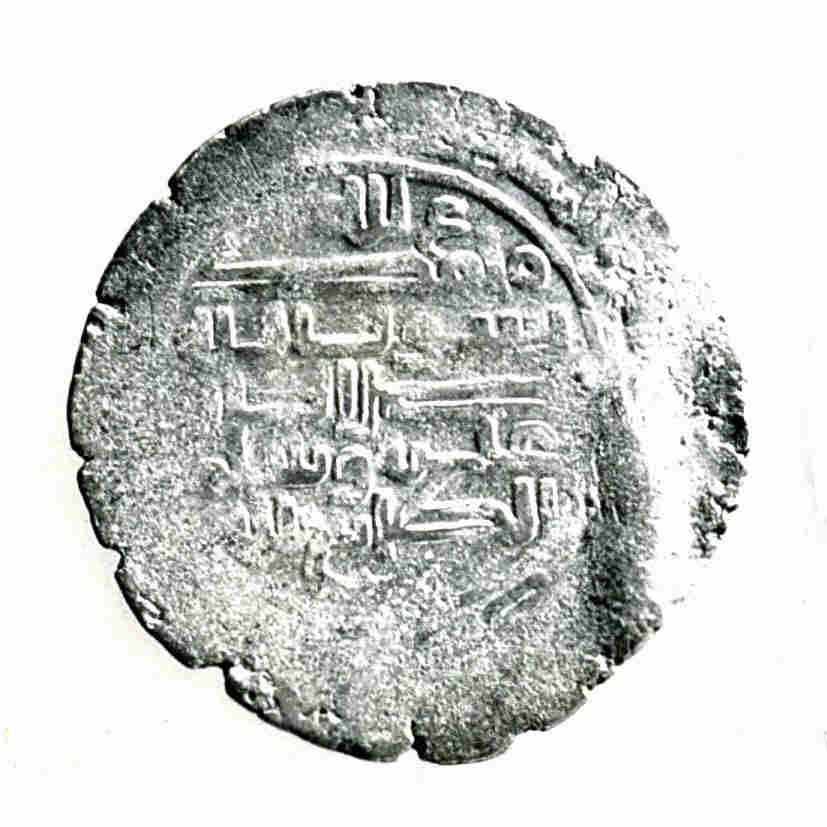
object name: coin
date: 977-982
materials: silver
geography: iran